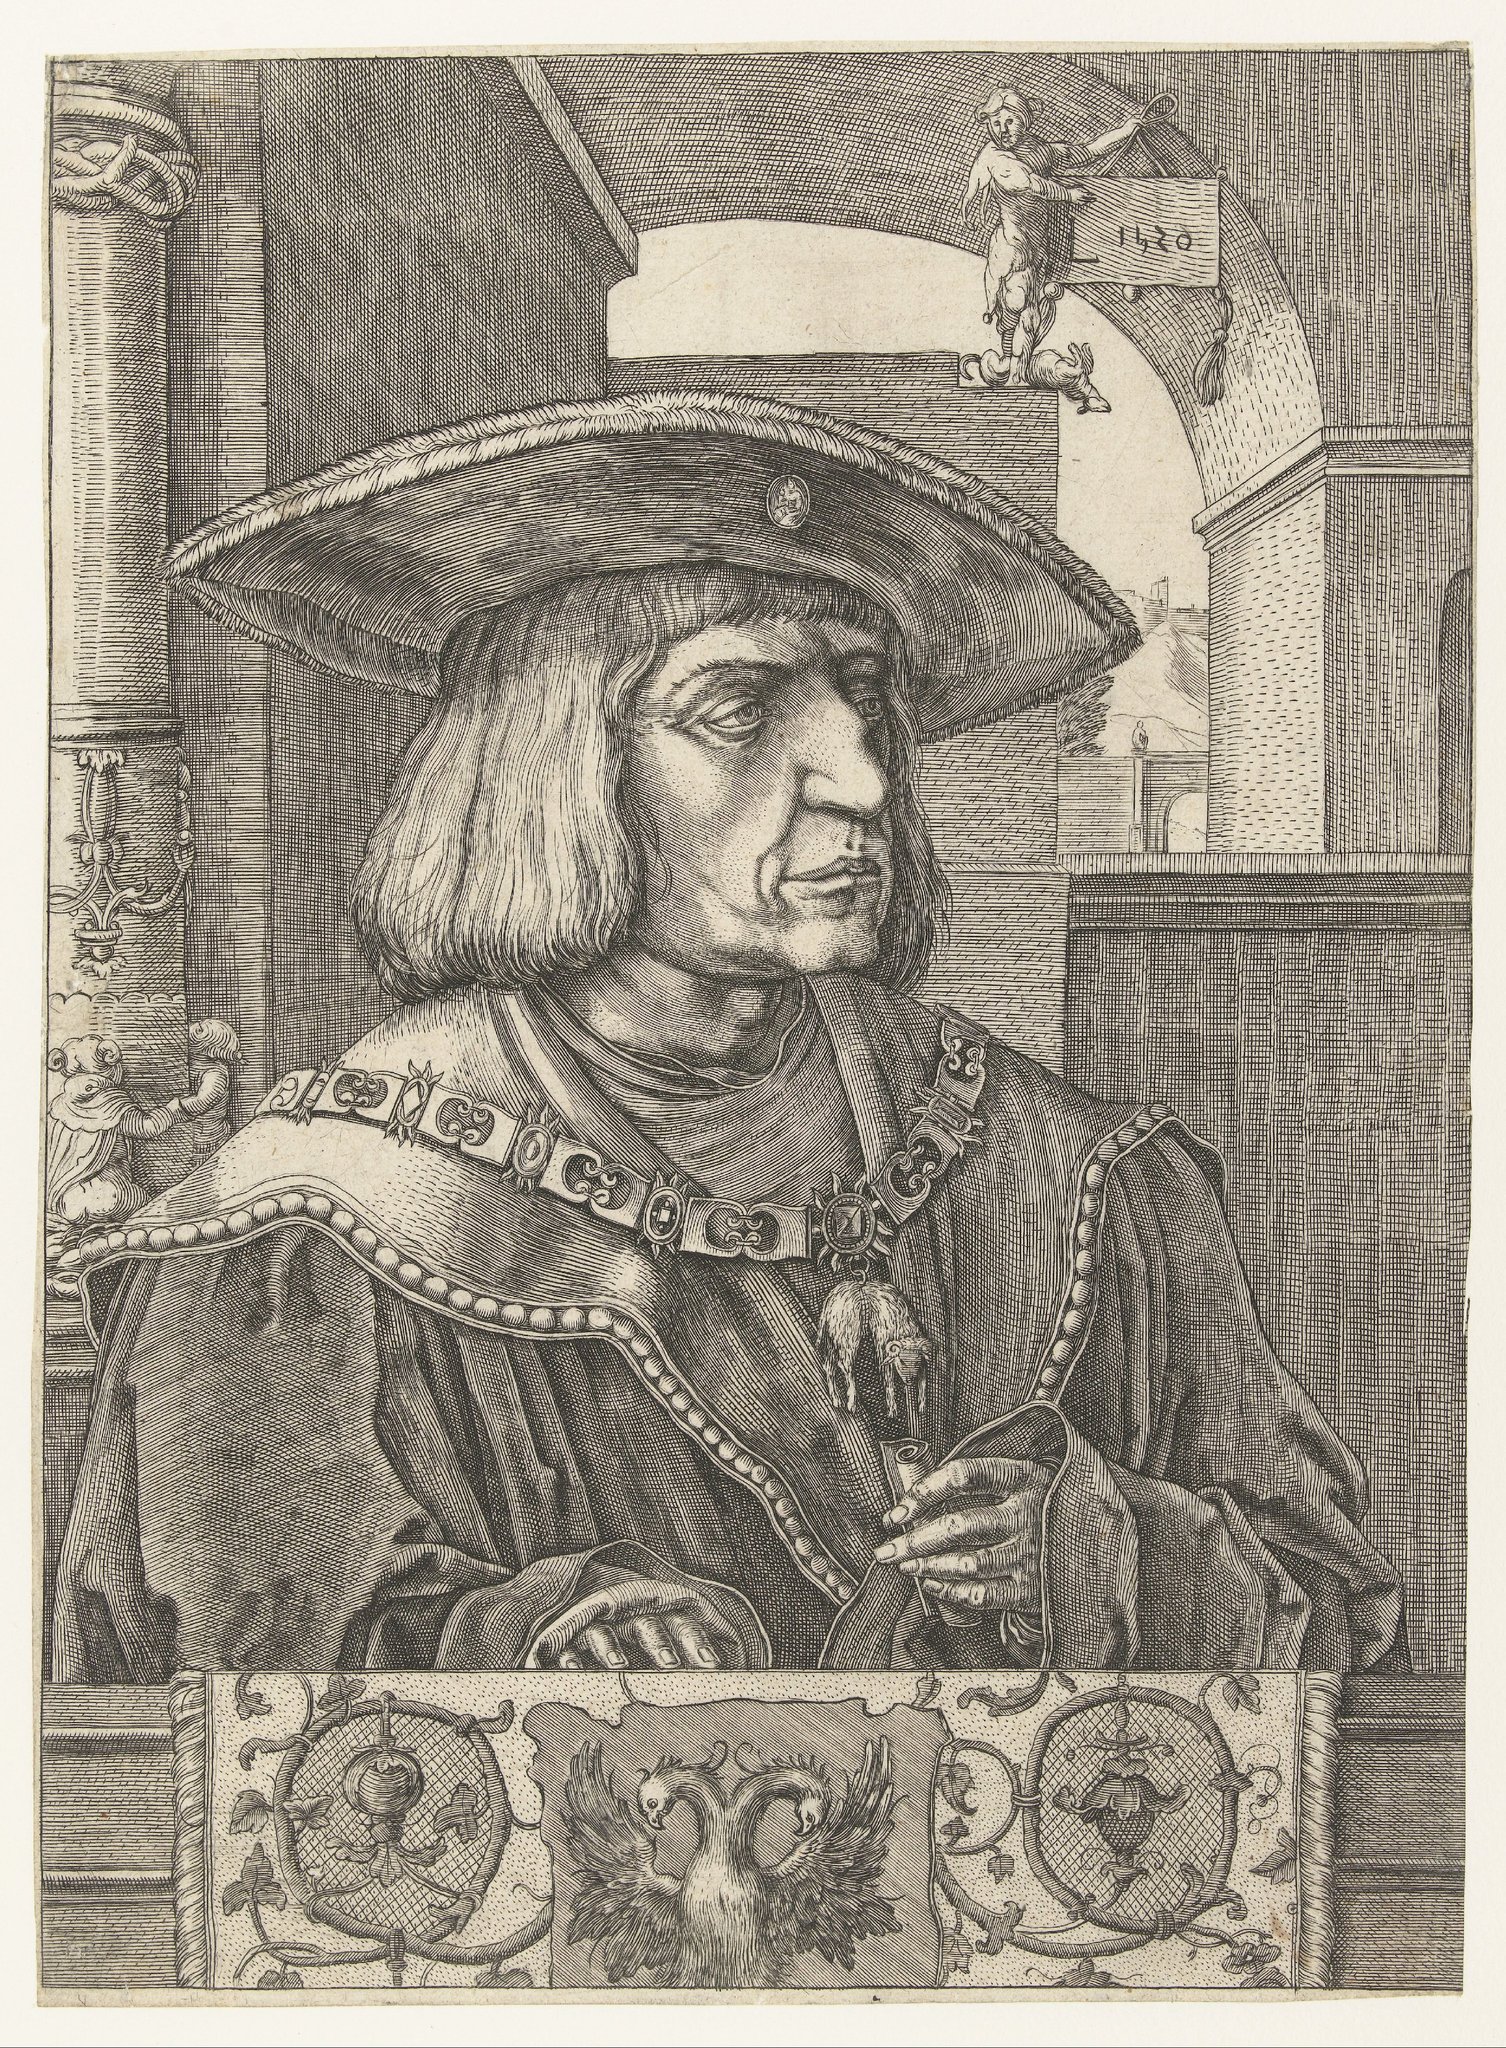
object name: print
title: Portret van keizer Maximiliaan I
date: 1581-1628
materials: paper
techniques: engraving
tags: maximilian i (holy roman emperor)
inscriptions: collector's mark: Lugt 240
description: Kopie in spiegelbeeld. Keizer Maximiliaan I met de keten van het Gulden Vlies om.